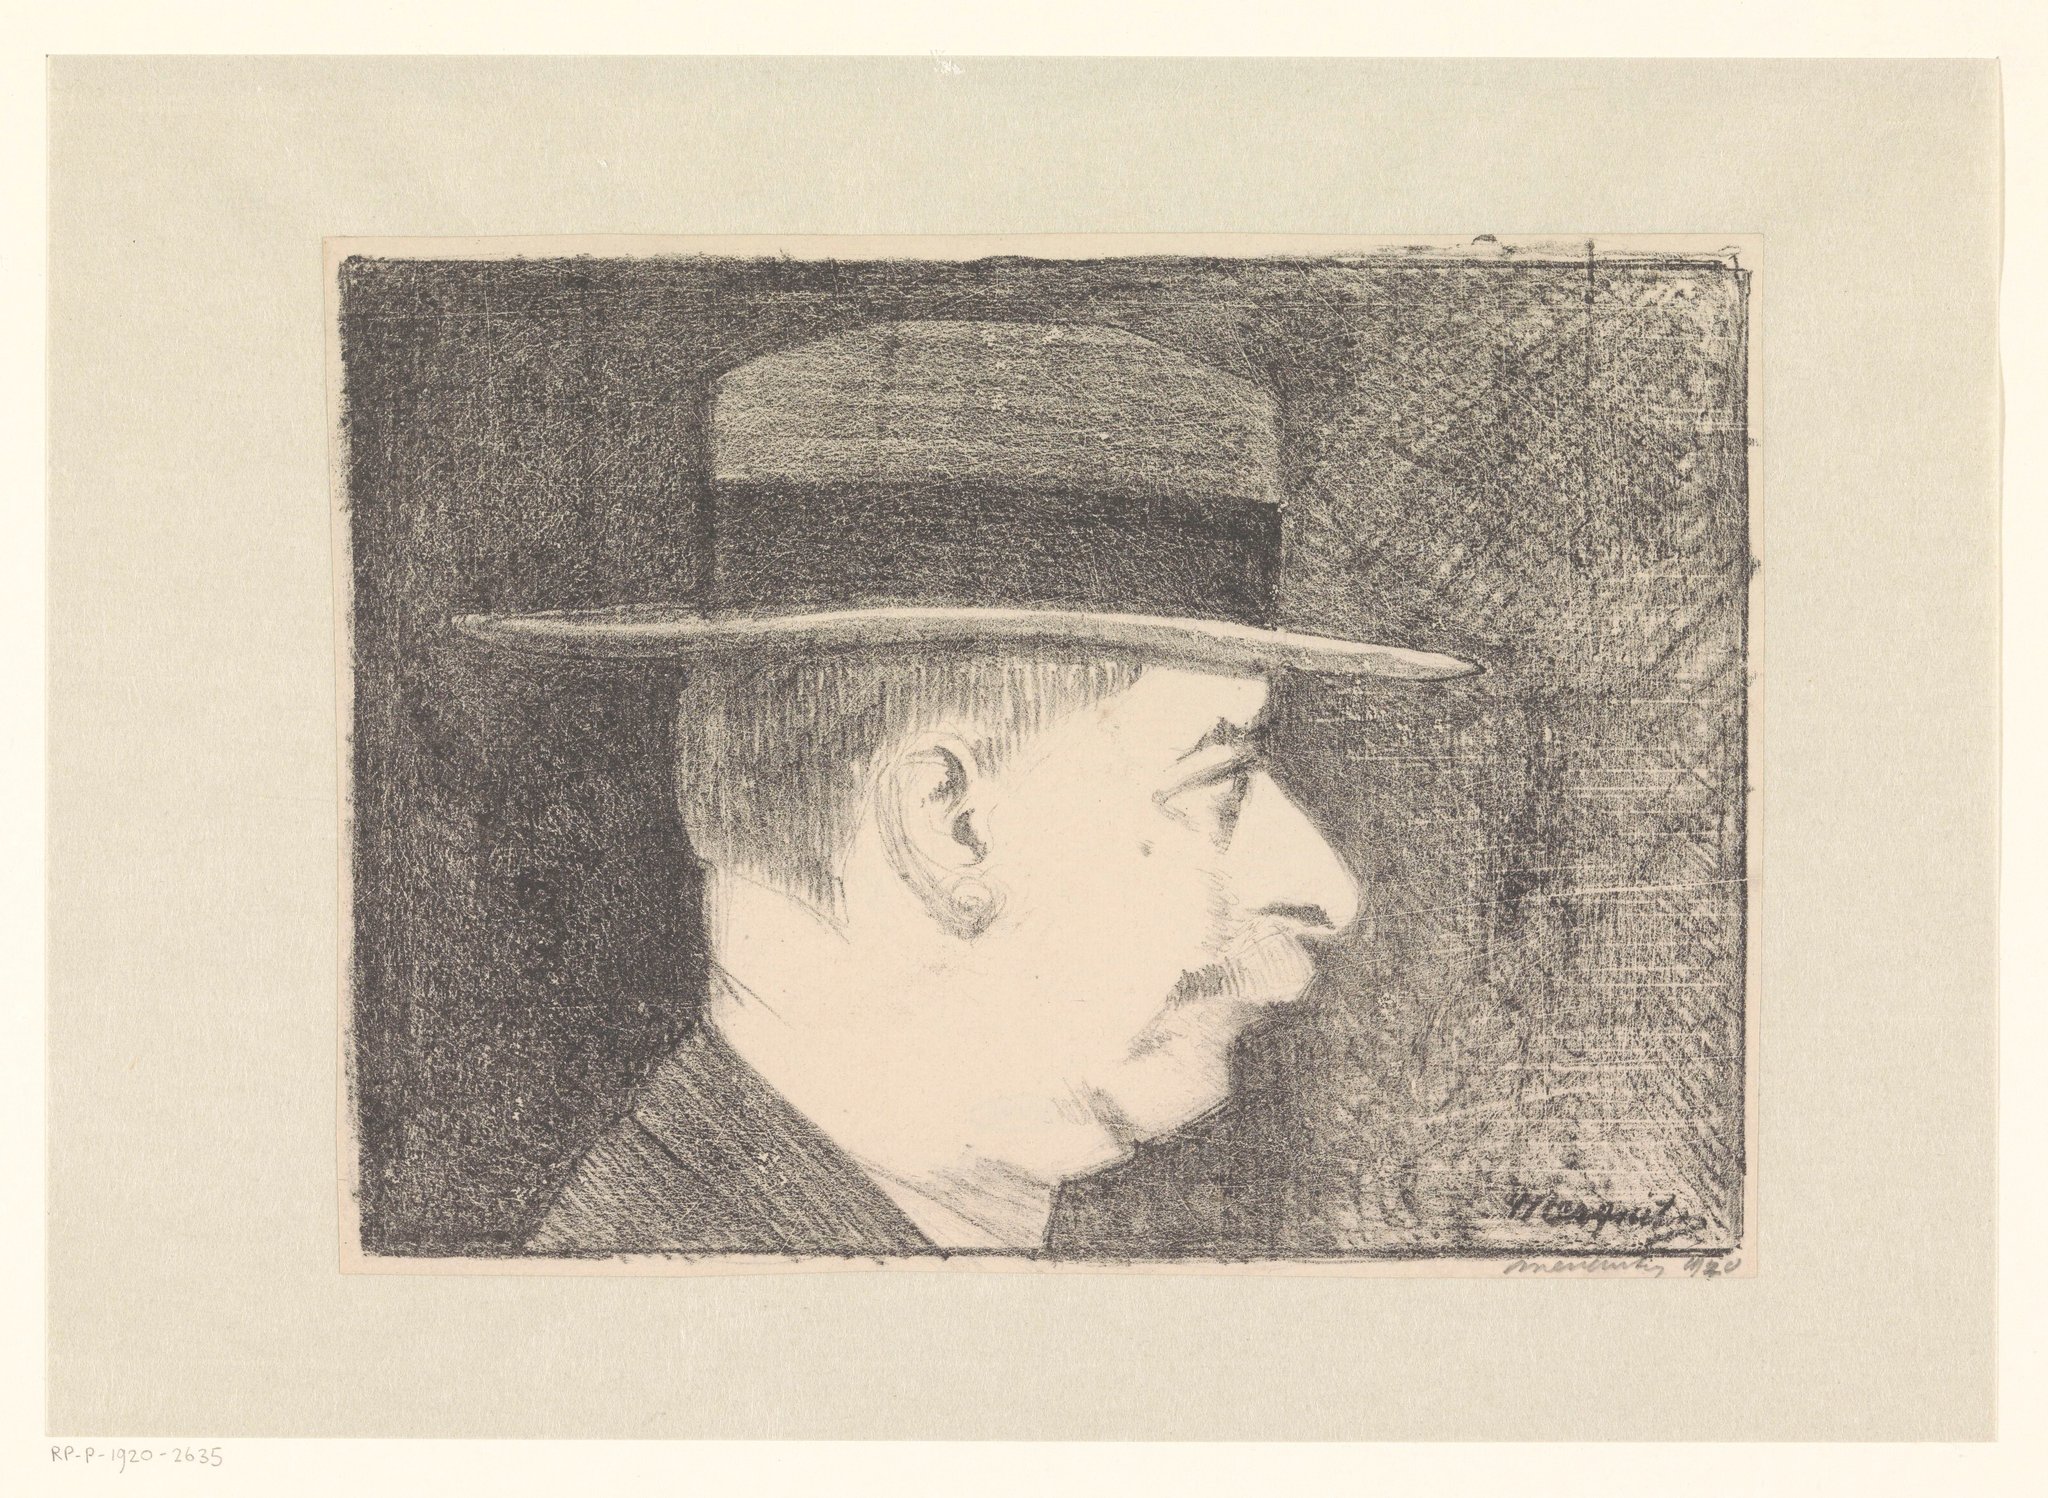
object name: print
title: Zelfportret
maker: samuel jessurun de mesquita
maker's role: draughtsman, print maker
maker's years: 1868-1944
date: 1920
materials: paper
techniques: lithograph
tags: amsterdam, print maker, draughtsman, samuel jessurun de mesquita, head-gear: hat, portrait, self-portrait of artist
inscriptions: collector's mark: Lugt 2228